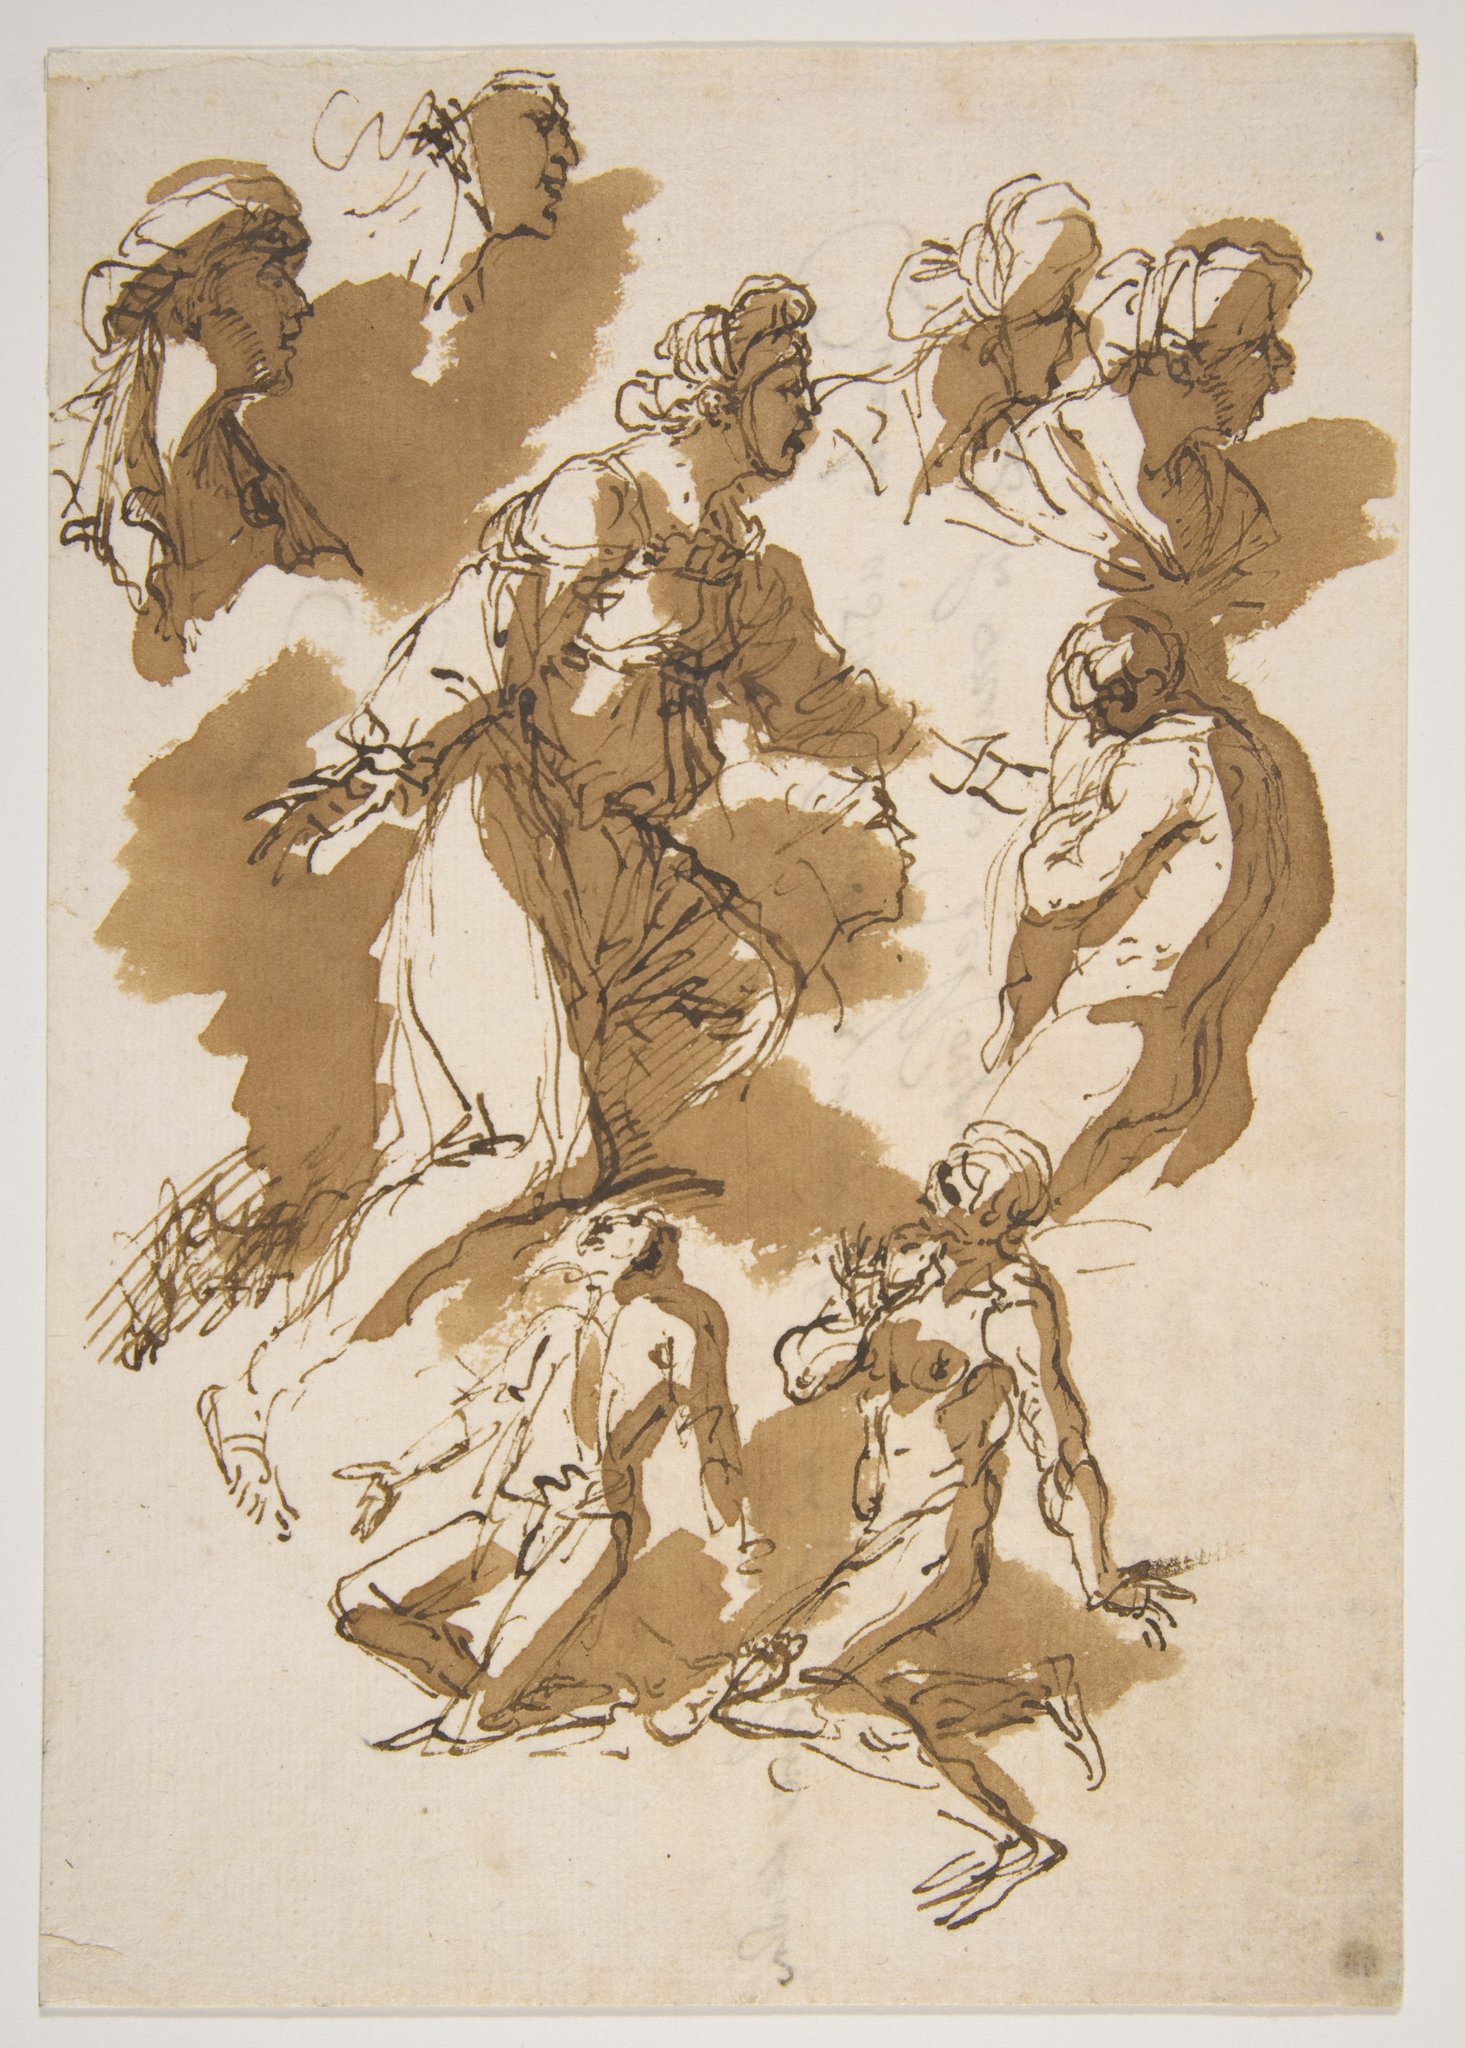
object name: drawing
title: Studies of Kneeling Figures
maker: salvator rosa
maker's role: artist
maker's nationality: italian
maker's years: 1615-1673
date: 1615-1673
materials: ink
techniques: brush, pen, wash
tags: human figures